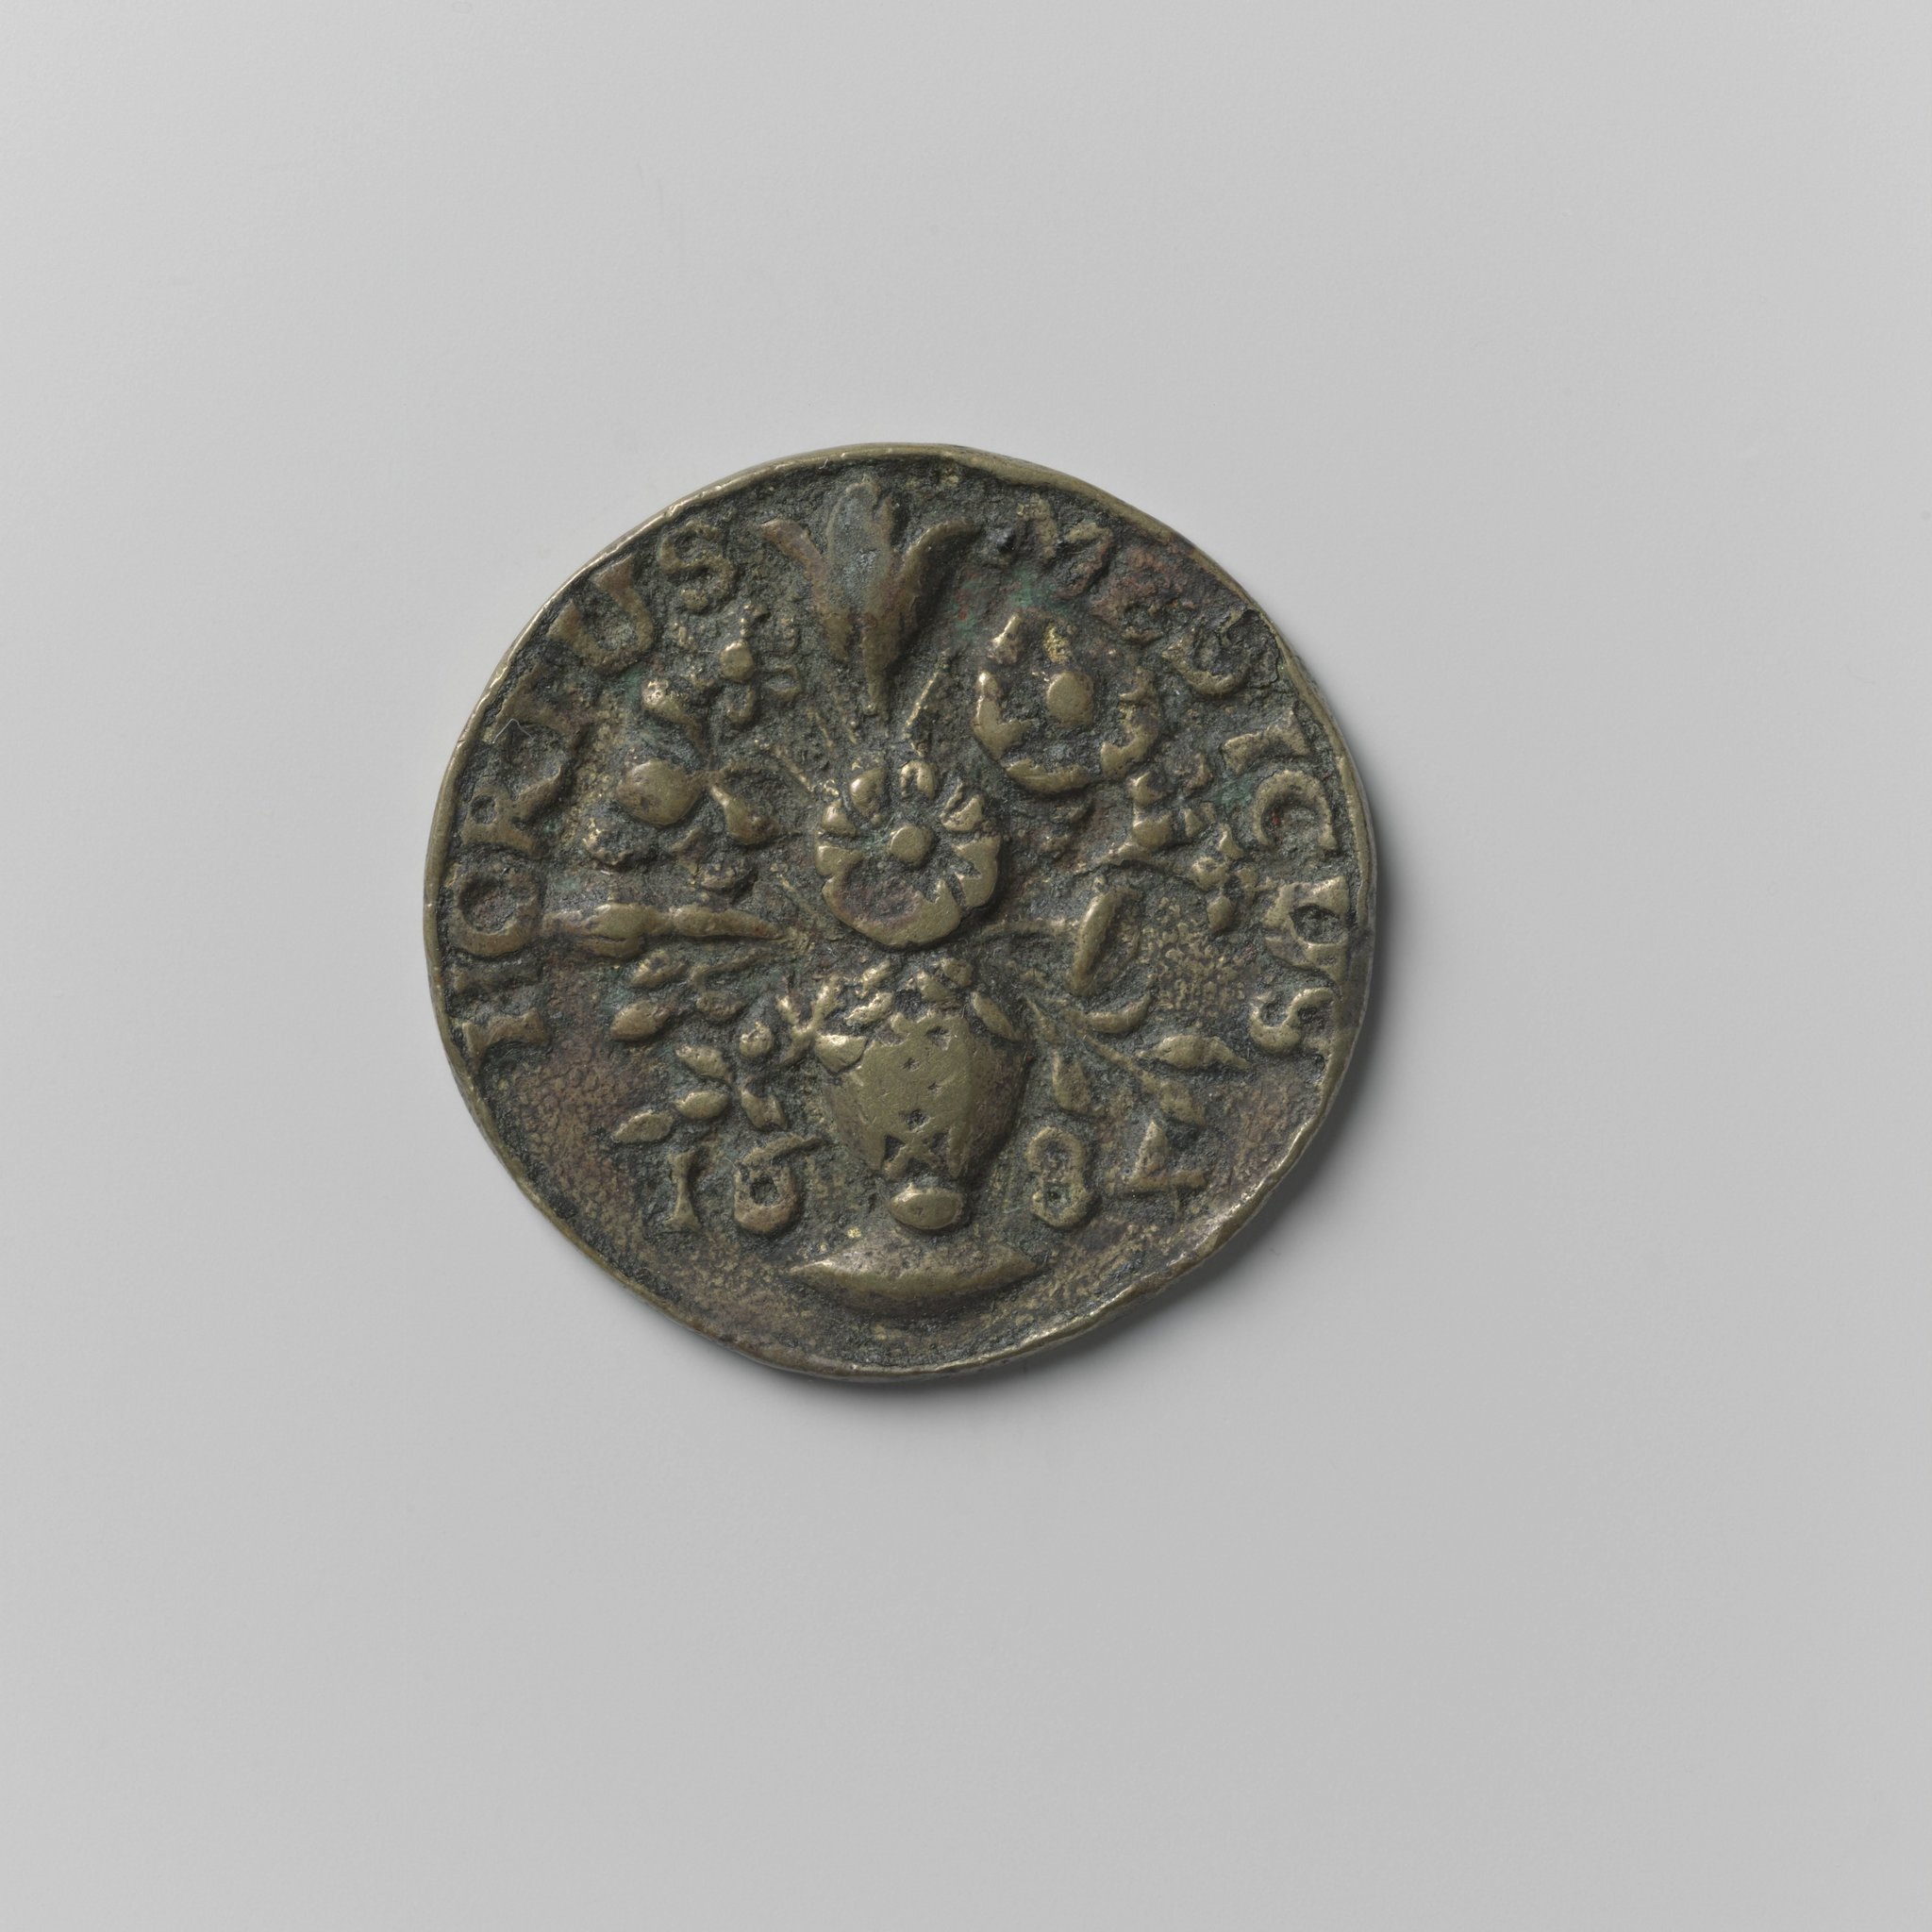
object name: medal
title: Collegium Medicum te Amsterdam, toegangspenning voor de hortus medicus voor apothekersleerling Jacobus Scheffer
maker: Anonymous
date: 1756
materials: brass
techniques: casting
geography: amsterdam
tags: amsterdam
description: Messing penning. Voorzijde: vaas met bloemen tussen jaartal; op vaas:wapenschild binnen omschrift. Keerzijde: opschrift